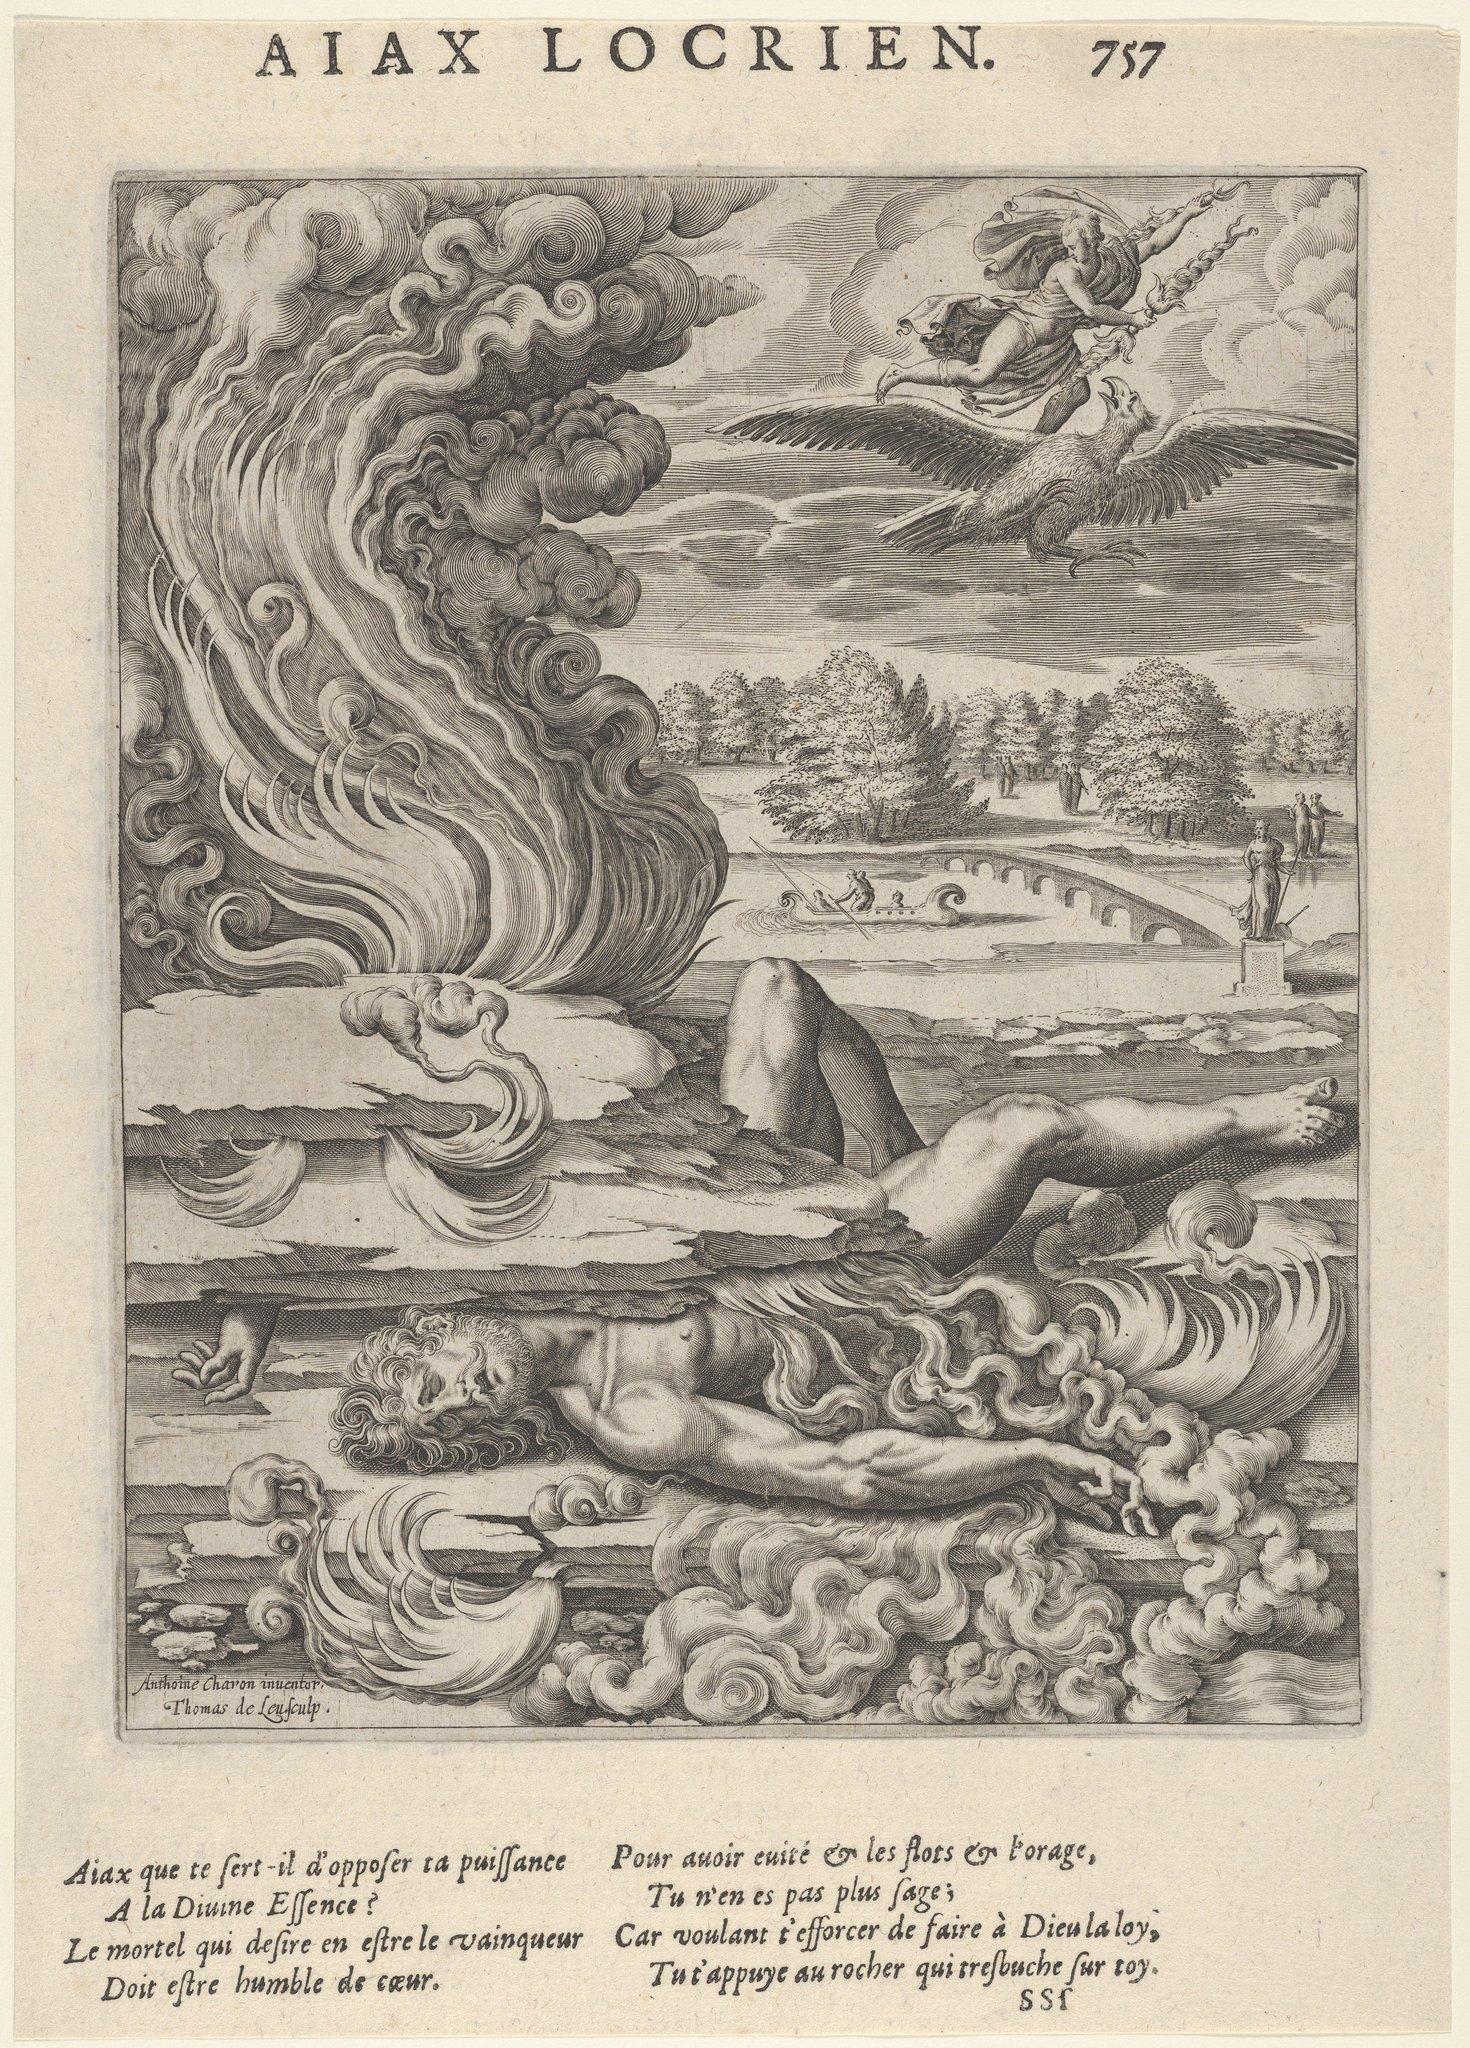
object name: print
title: Locrian Ajax (Ajax Locrien), from "Les Images ou Tableaux de platte peinture des deux Philostrates Sophistes grecs..."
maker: thomas de leu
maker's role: artist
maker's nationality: french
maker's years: 1560-1620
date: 1614-1615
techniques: engraving, letterpress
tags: eagles,men,fire,ajax